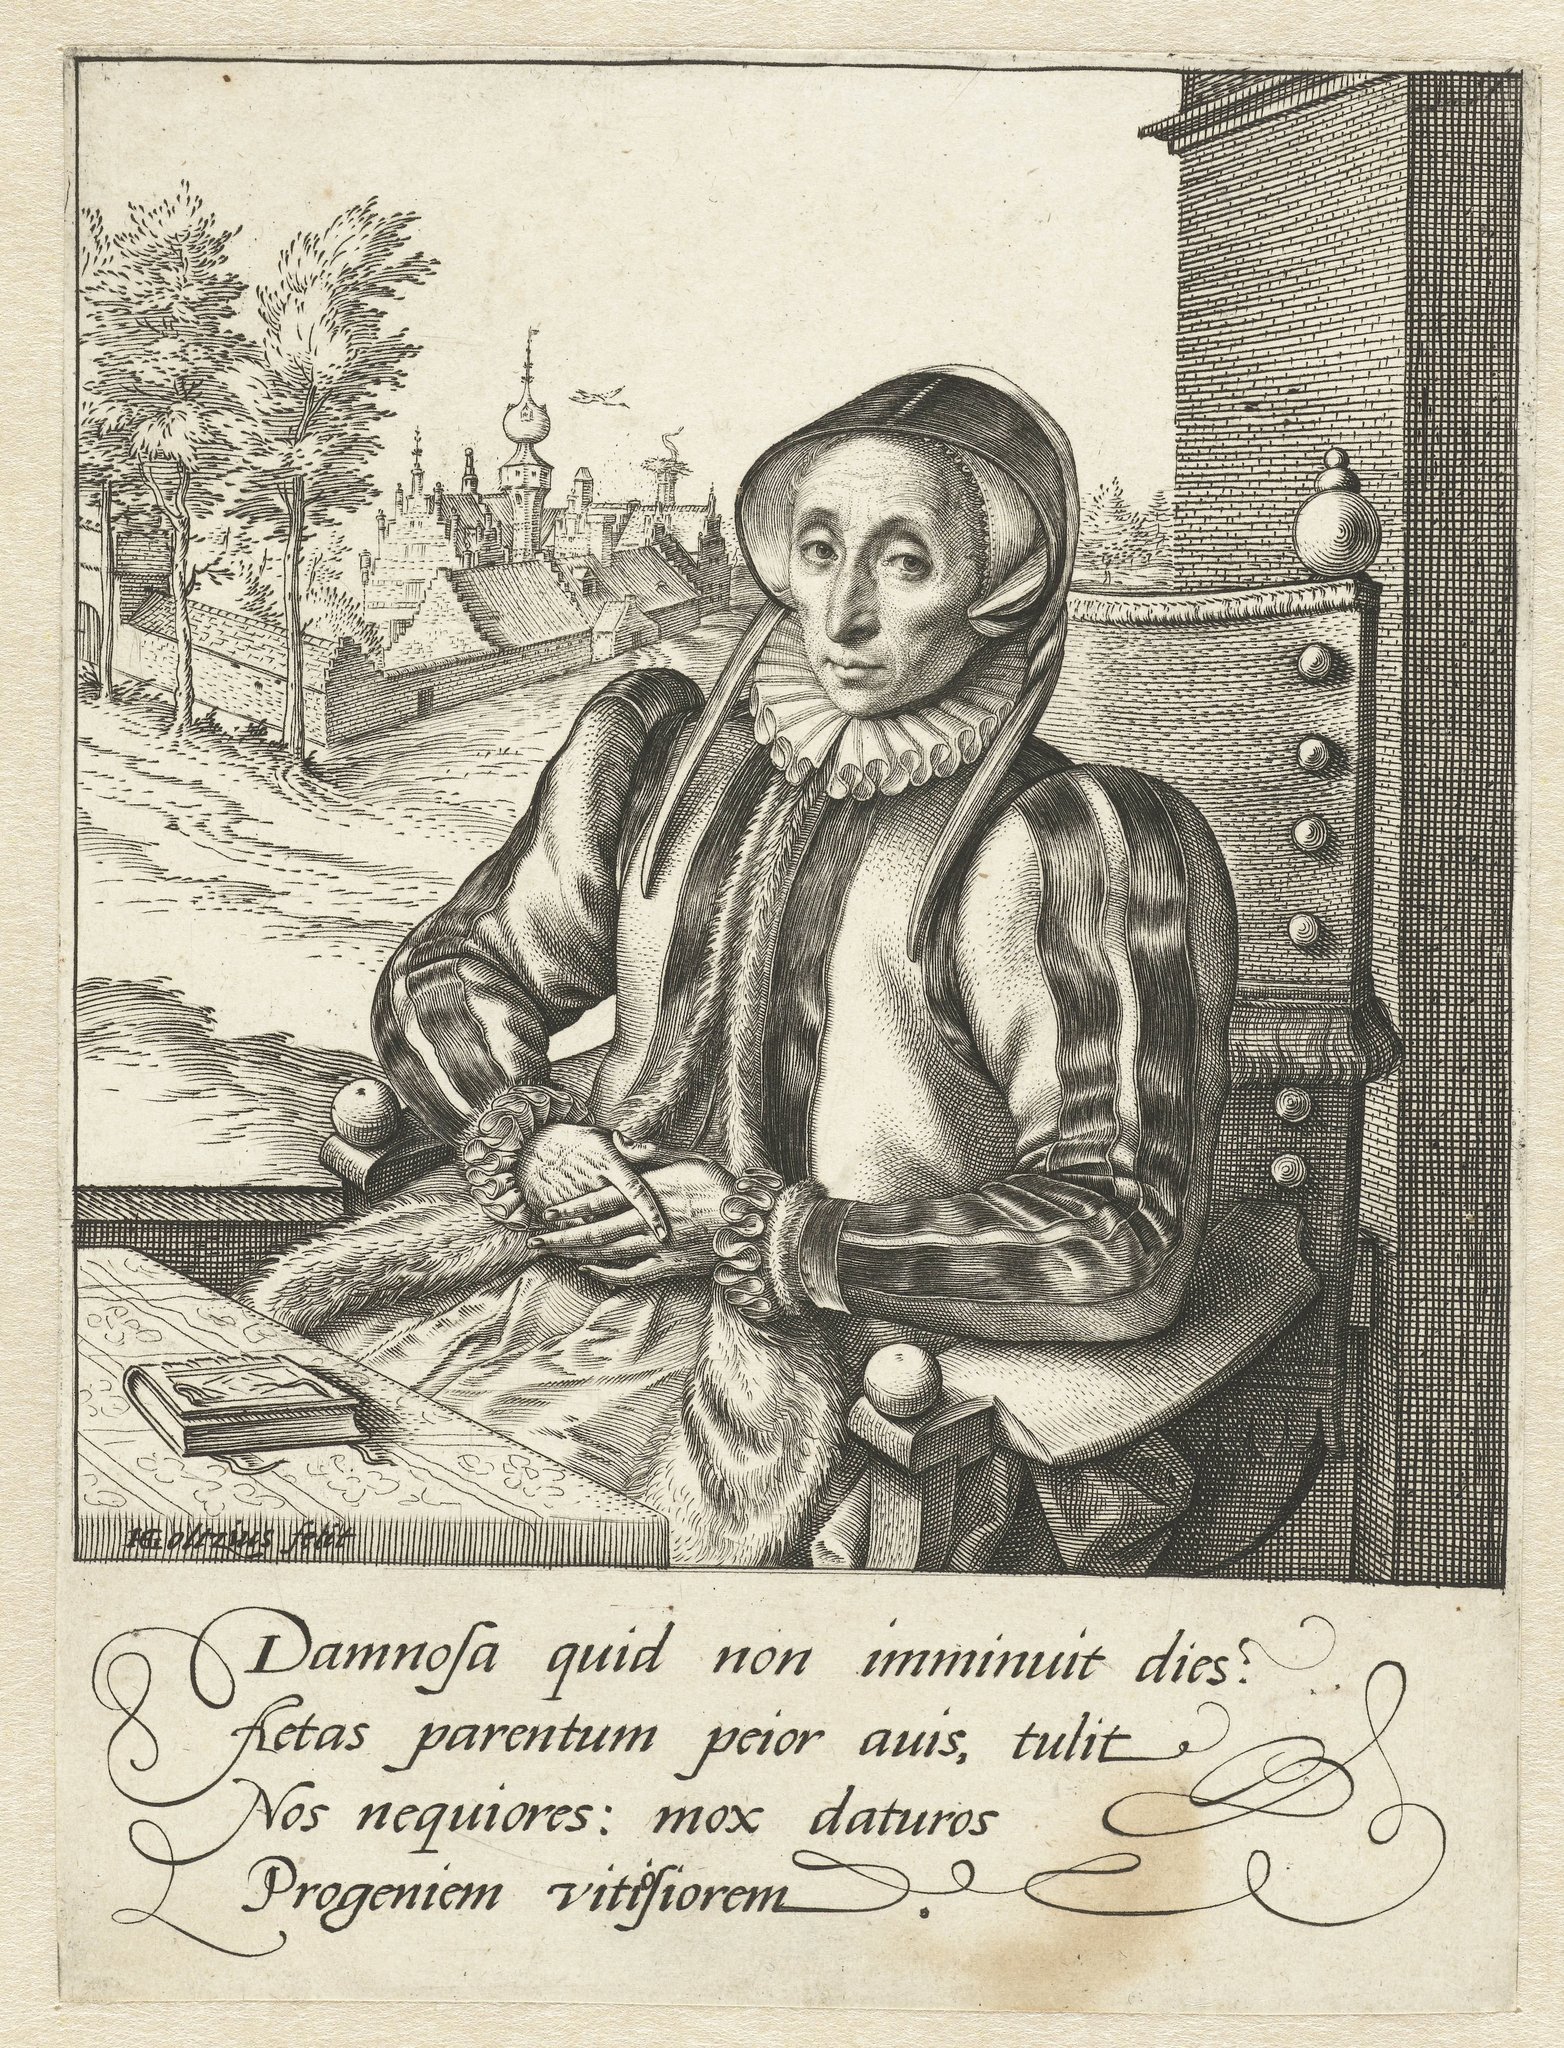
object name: print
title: Portret van Anna Fullings, moeder van de kunstenaar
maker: hendrick goltzius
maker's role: draughtsman, painter, print maker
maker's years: 1558-1617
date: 1581-1585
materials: paper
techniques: engraving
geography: haarlem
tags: historical persons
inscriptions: signature: ‘HGoltzius fecit’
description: Het is niet geheel duidelijk wie hier is afgebeeld. Door Mariette en Muller beschreven als Catharina (Katharina) Decker; de voorstudie voor de eerste staat draagt echter het opschrift 'Agatha Scholier' en door Frits Meyers werd deze vrouw, mede op basis van het onderschrift, gezien als de moeder van de kunstenaar (Anna Fullings). TIB vindt deze laatste toeschrijving het meest overtuigend. Tekening die voor deze staat als model gediend heeft, bevindt zich in Berlijn (zie literatuur). Jacobs, G.